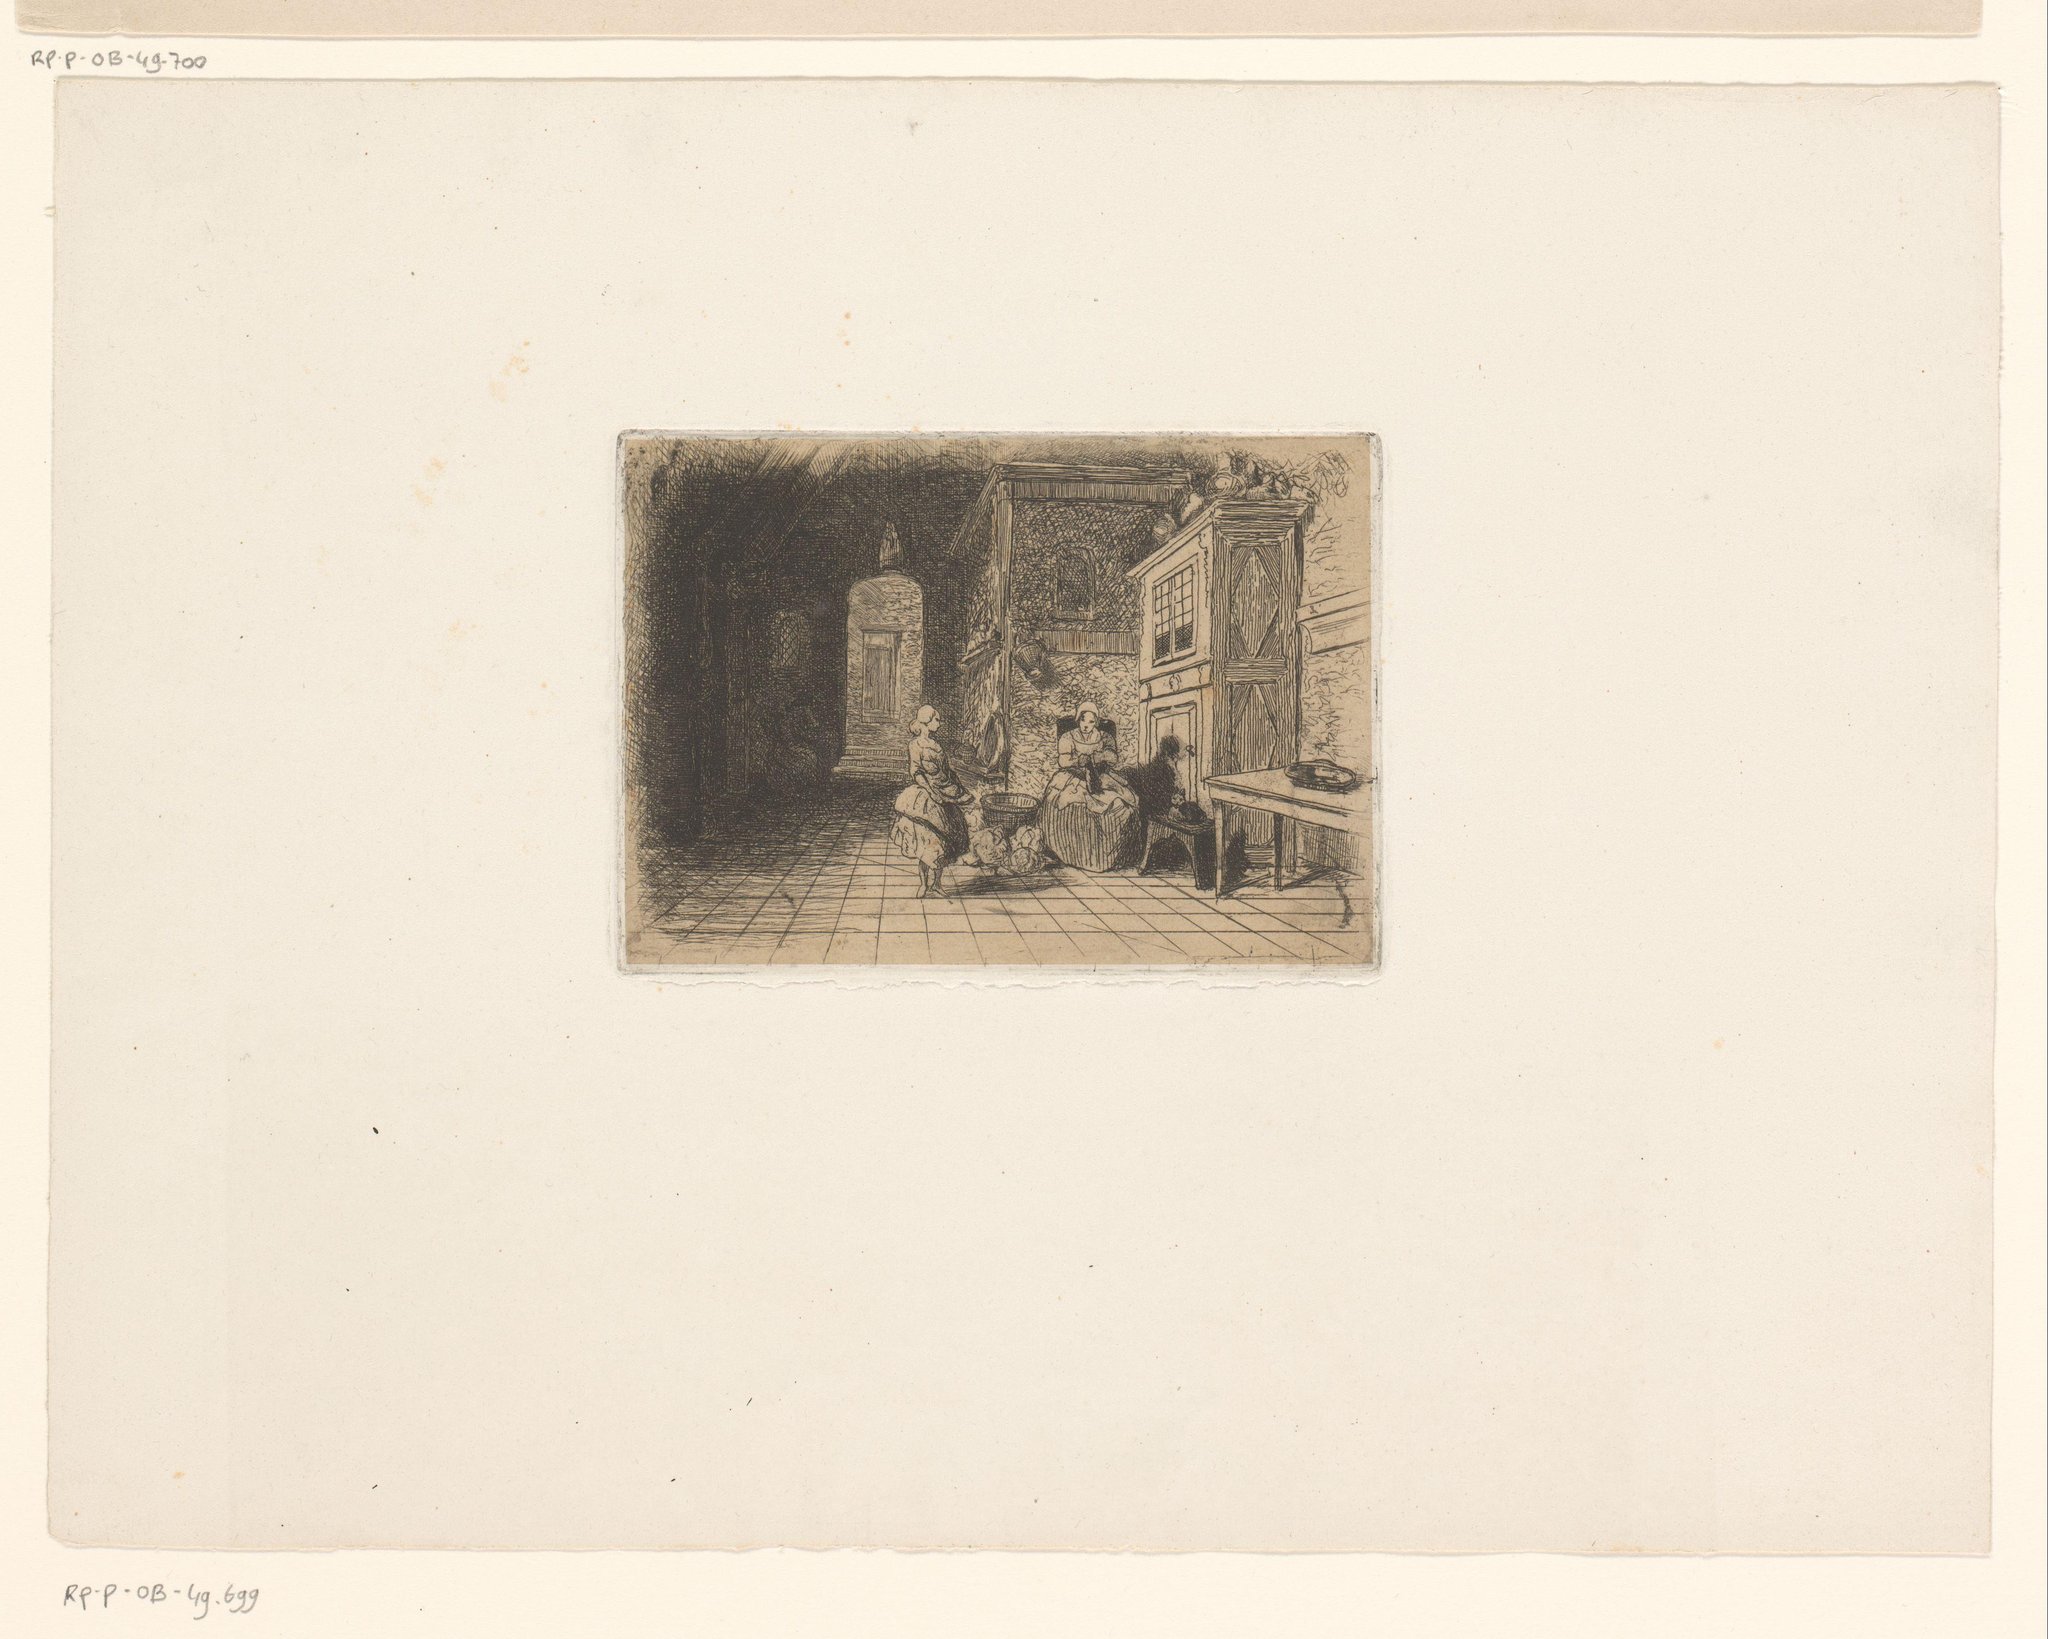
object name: print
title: Interieur met twee vrouwen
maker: polynice auguste viette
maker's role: print maker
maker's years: 1814-1891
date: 1851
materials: paper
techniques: etching, roulette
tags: kitchen-interior, house personnel, servants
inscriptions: collector's mark: Lugt 2228